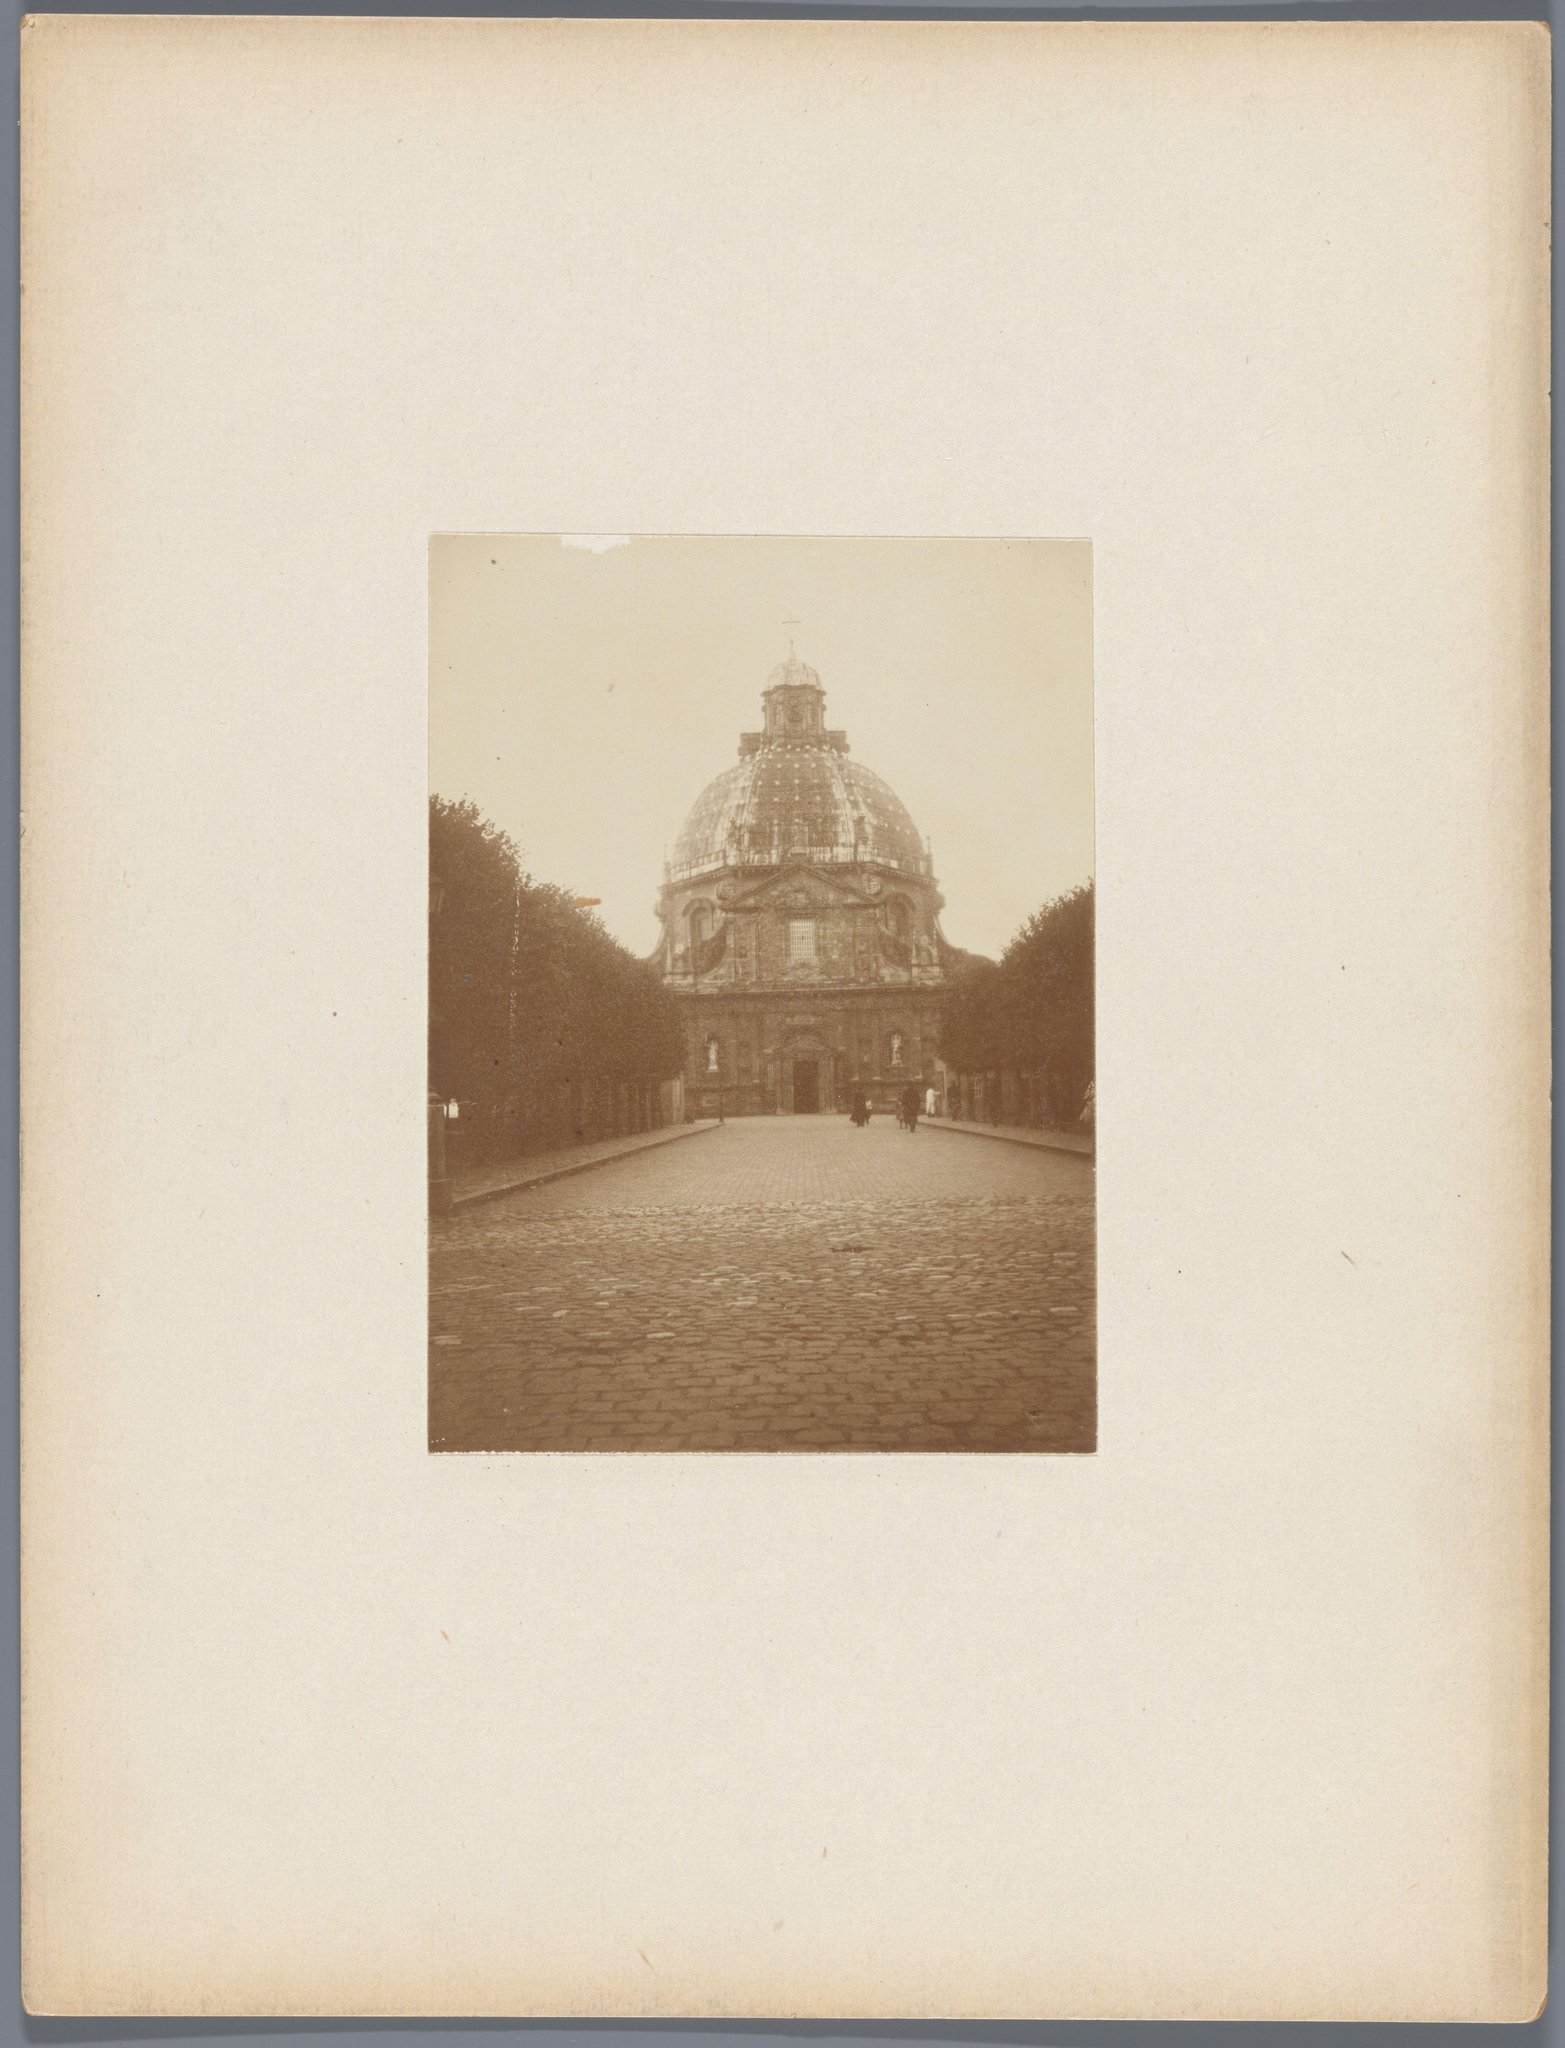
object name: photograph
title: Basiliek van Onze-Lieve-Vrouw van Scherpenheuvel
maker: Anonymous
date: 1907-1910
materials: cardboard, photographic support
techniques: collodion silver print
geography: scherpenheuvel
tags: church (exterior)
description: Basiliek van Onze-Lieve-Vrouw van Scherpenheuvel. Onderdeel van het losbladige fotoalbum met 39 foto's van een reis door Nederland, ca. 1907-1910.